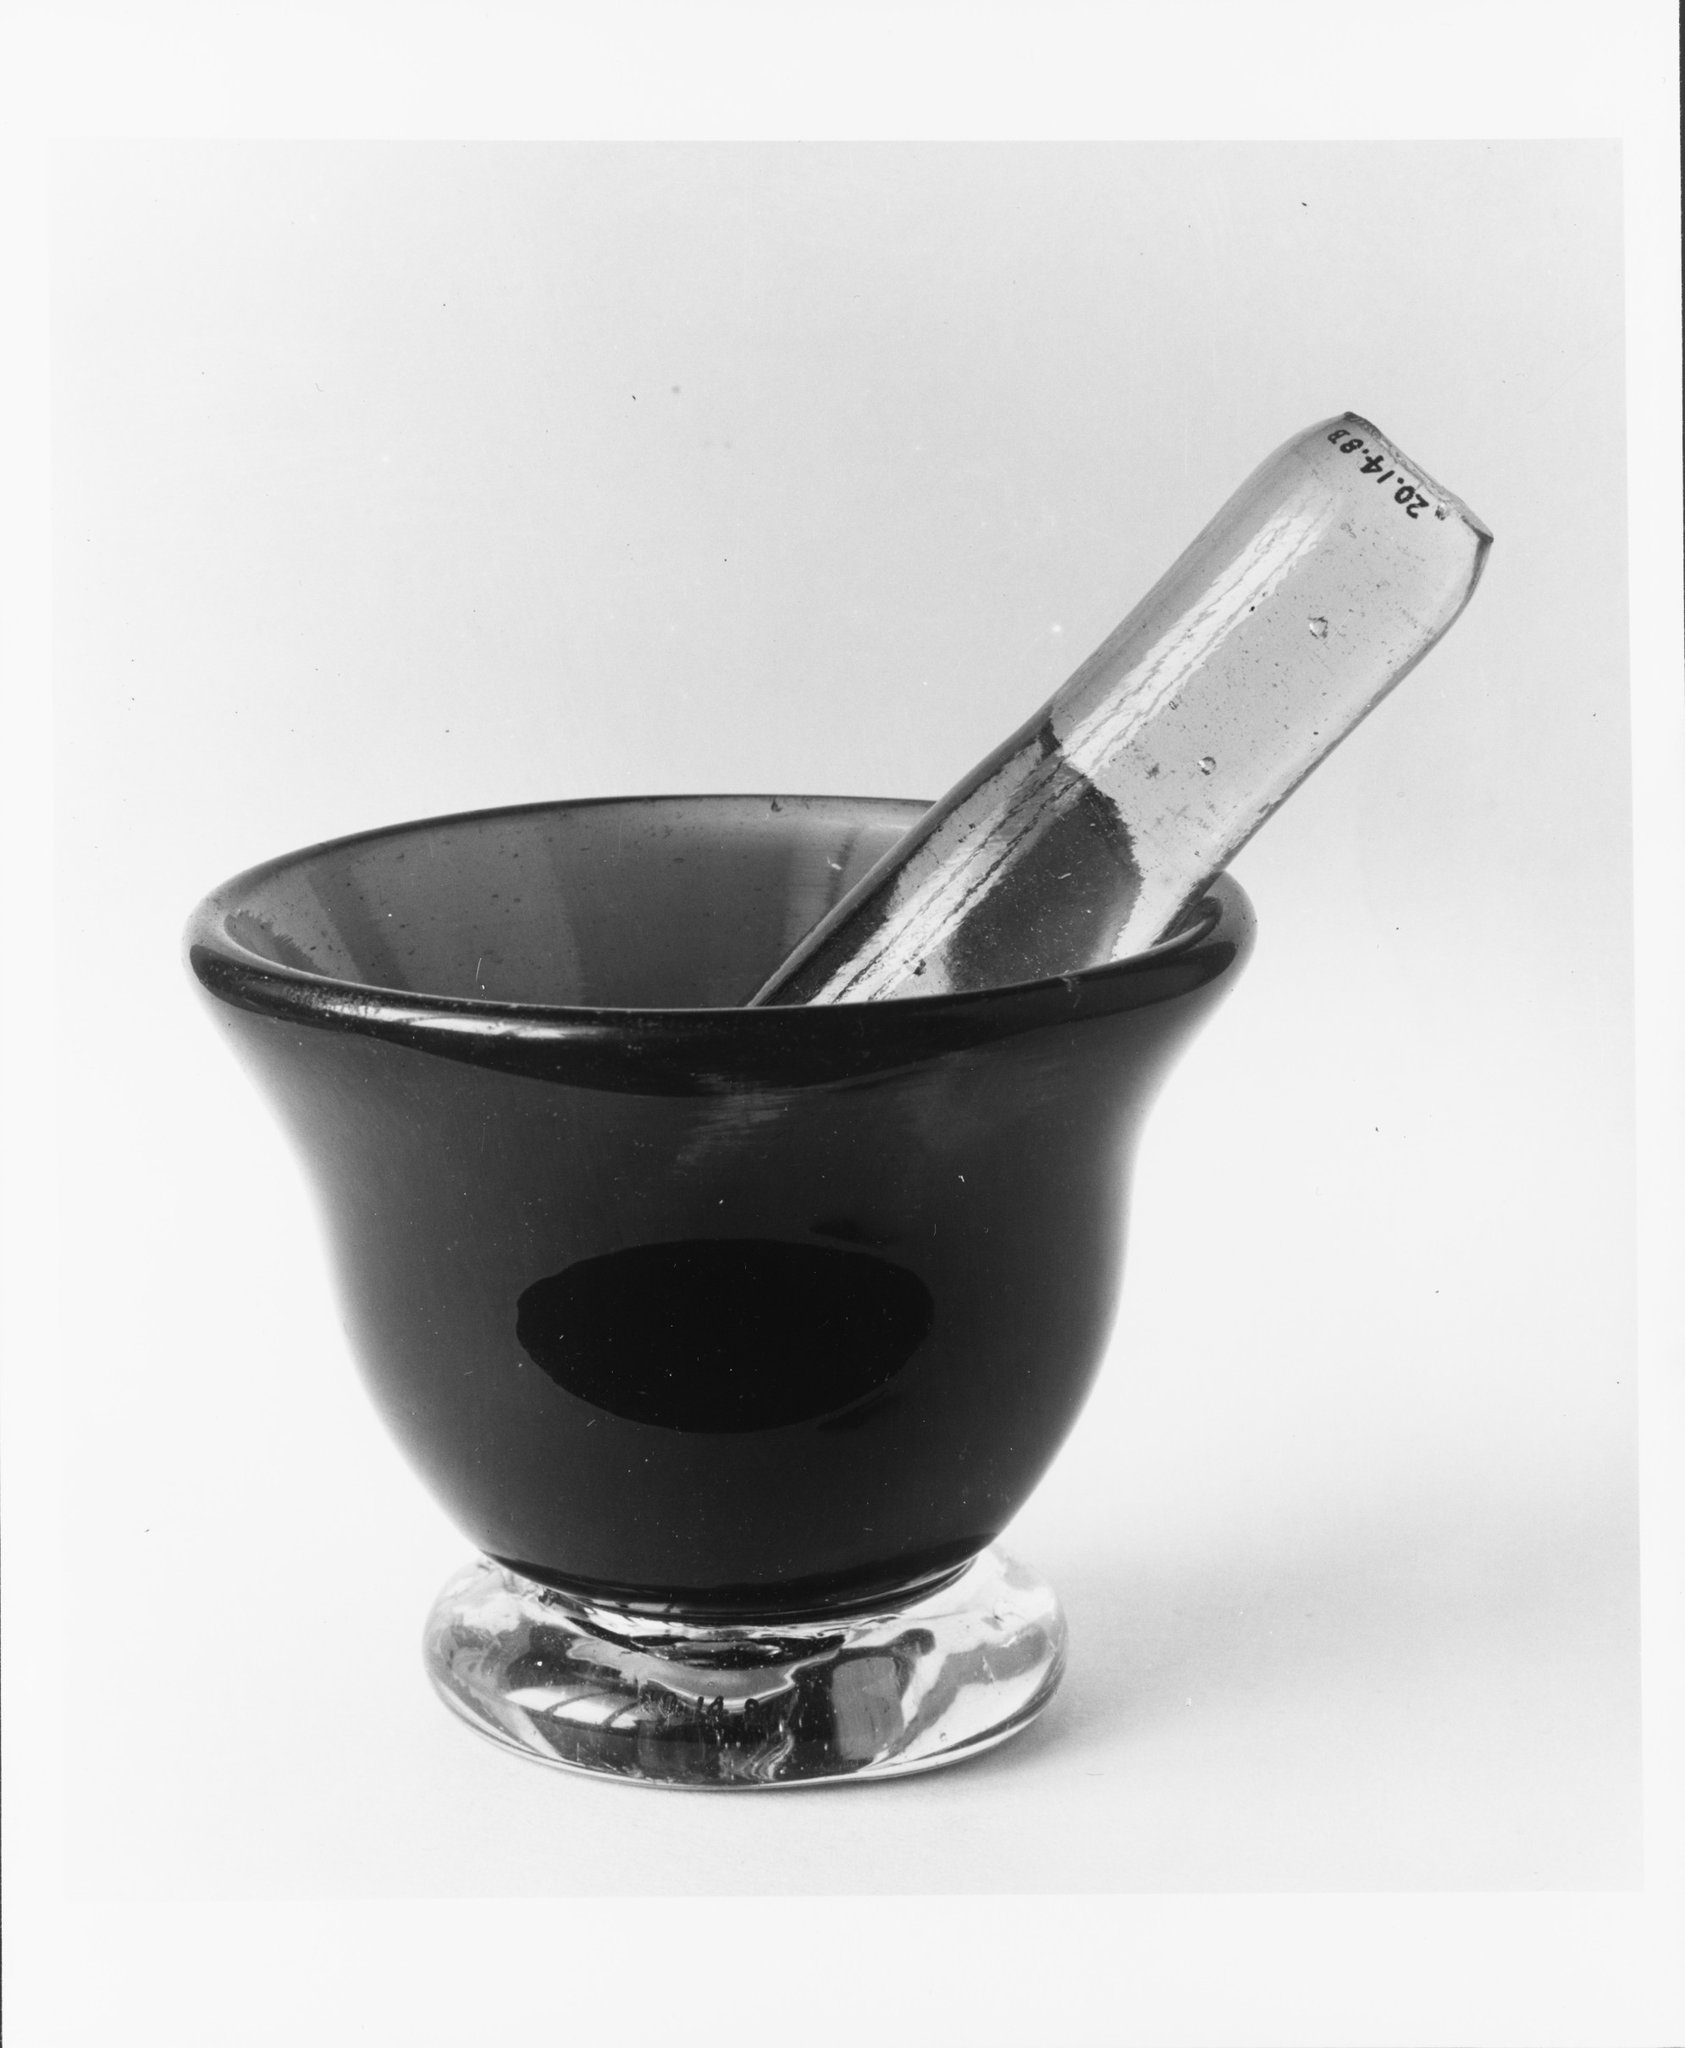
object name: mortar and pestle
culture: american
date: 1739-1780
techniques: glassblowing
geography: mid-atlantic